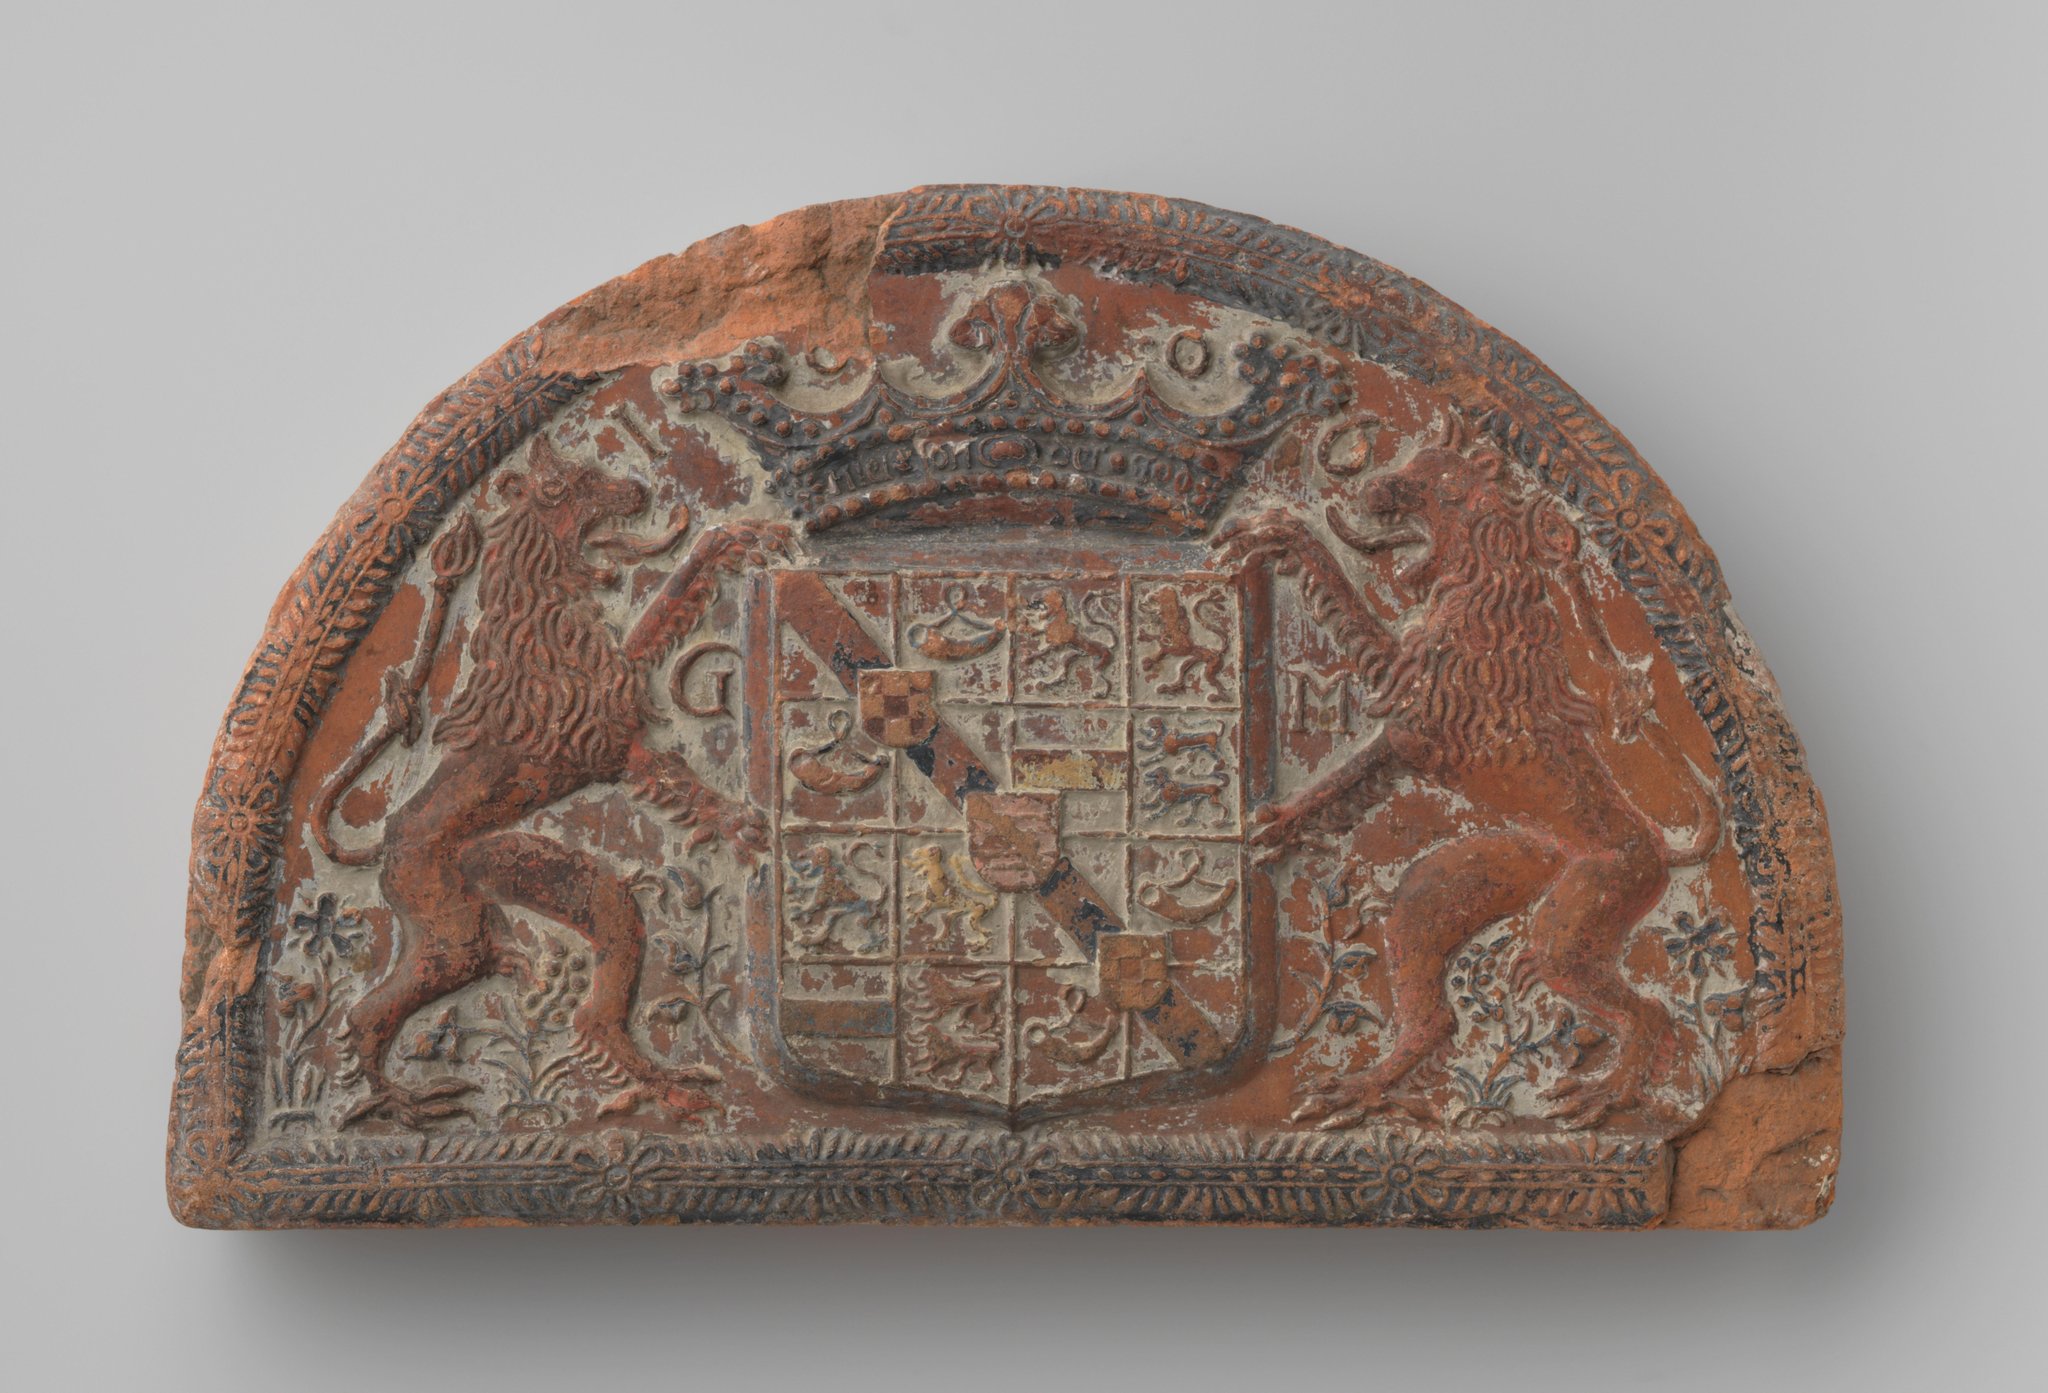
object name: haarddeksteen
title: Haarddeksteen met het wapen van Prins Maurits van Oranje Nassau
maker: Anonymous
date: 1567-1625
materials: brick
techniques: printing, firing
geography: netherlands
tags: the hague, maurice (prince of orange)